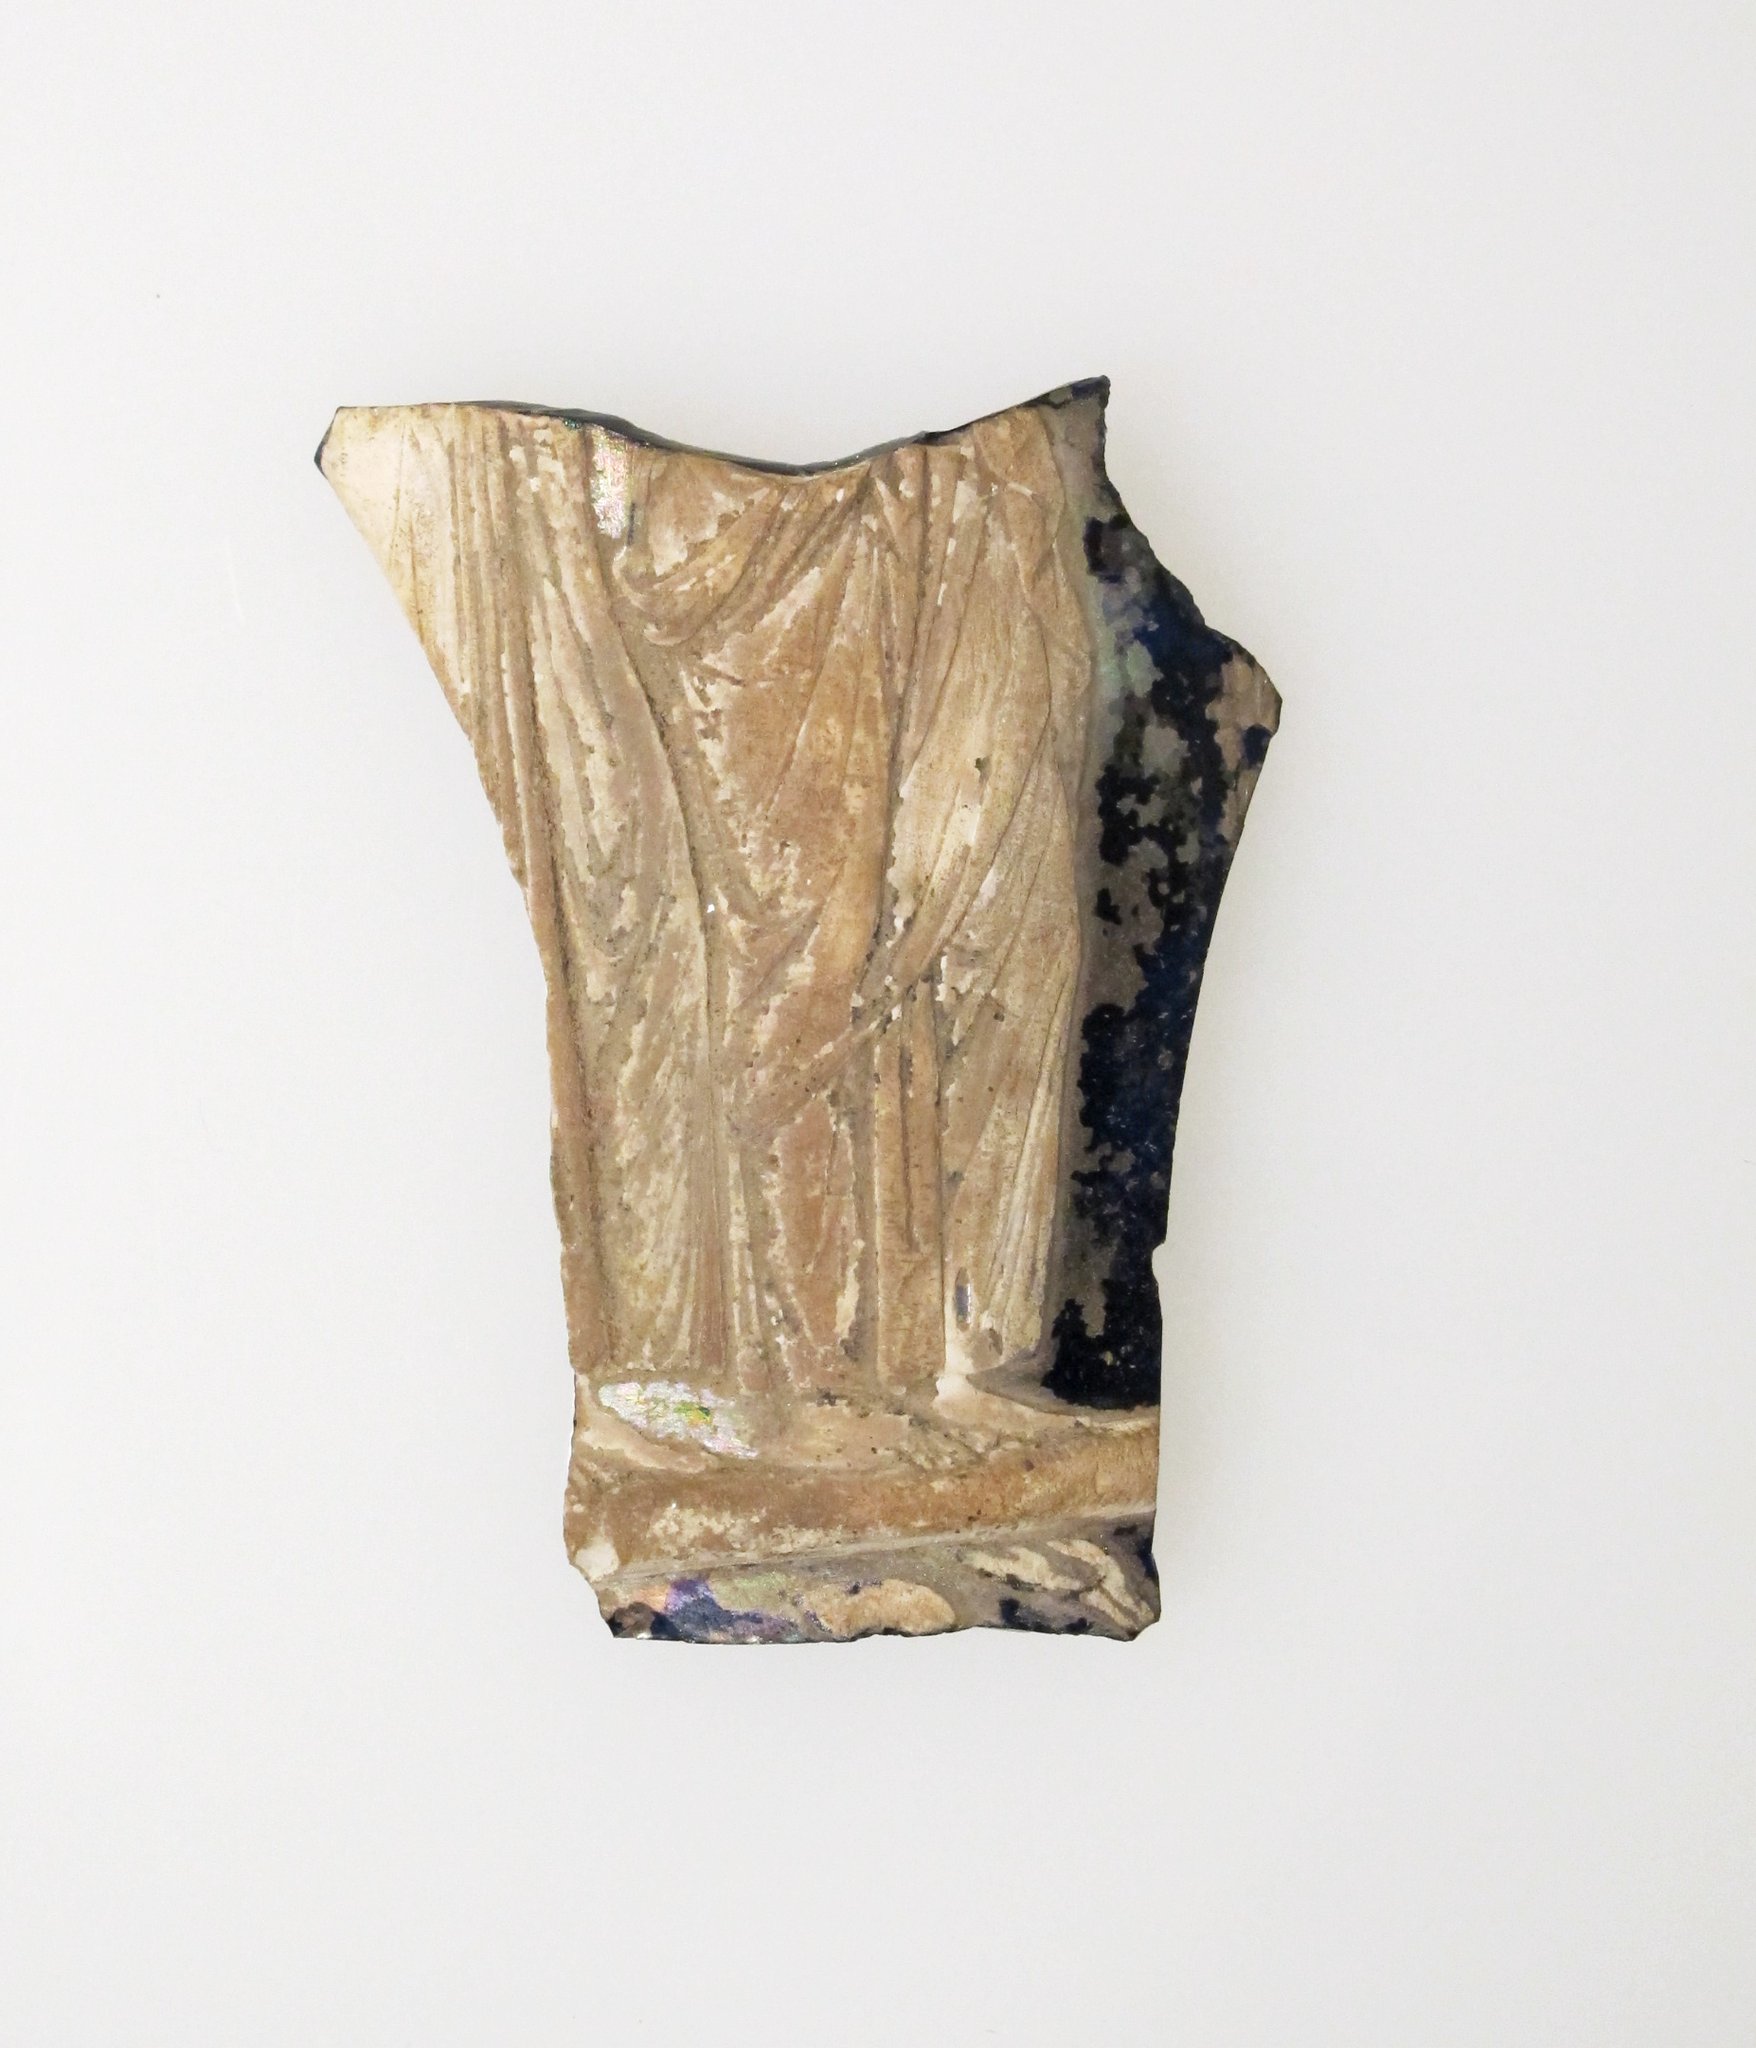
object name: cameo, fragment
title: Glass cameo fragment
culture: roman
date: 1-100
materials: glass